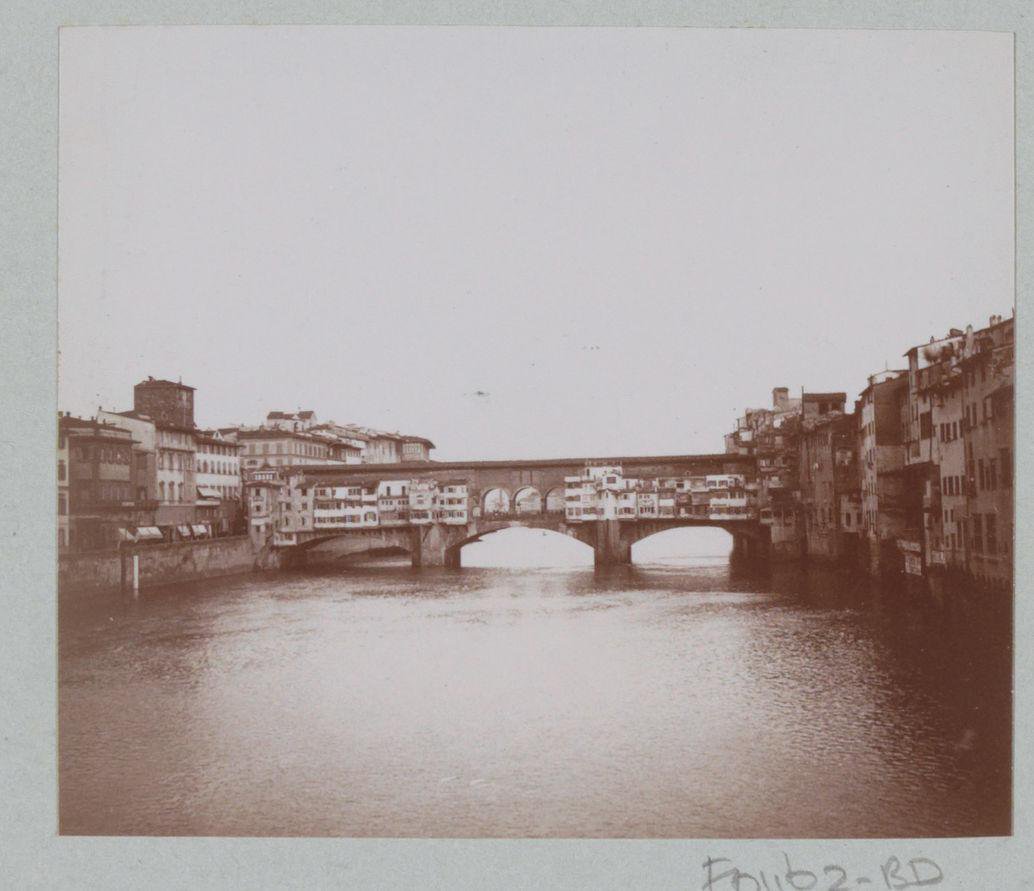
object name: photograph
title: Gezicht op de Ponte Vecchio over de Arno in Florence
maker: Anonymous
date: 1905-1910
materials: paper, photographic support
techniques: gelatin silver print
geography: florence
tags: river bank, bridge in city with structures, i.e. shops, houses, e.g. ponte vecchio in florence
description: Onderdeel van Fotoalbum van een Franse amateurfotograaf met bezienswaardigheden in Frankrijk, Zwitserland en Italië.